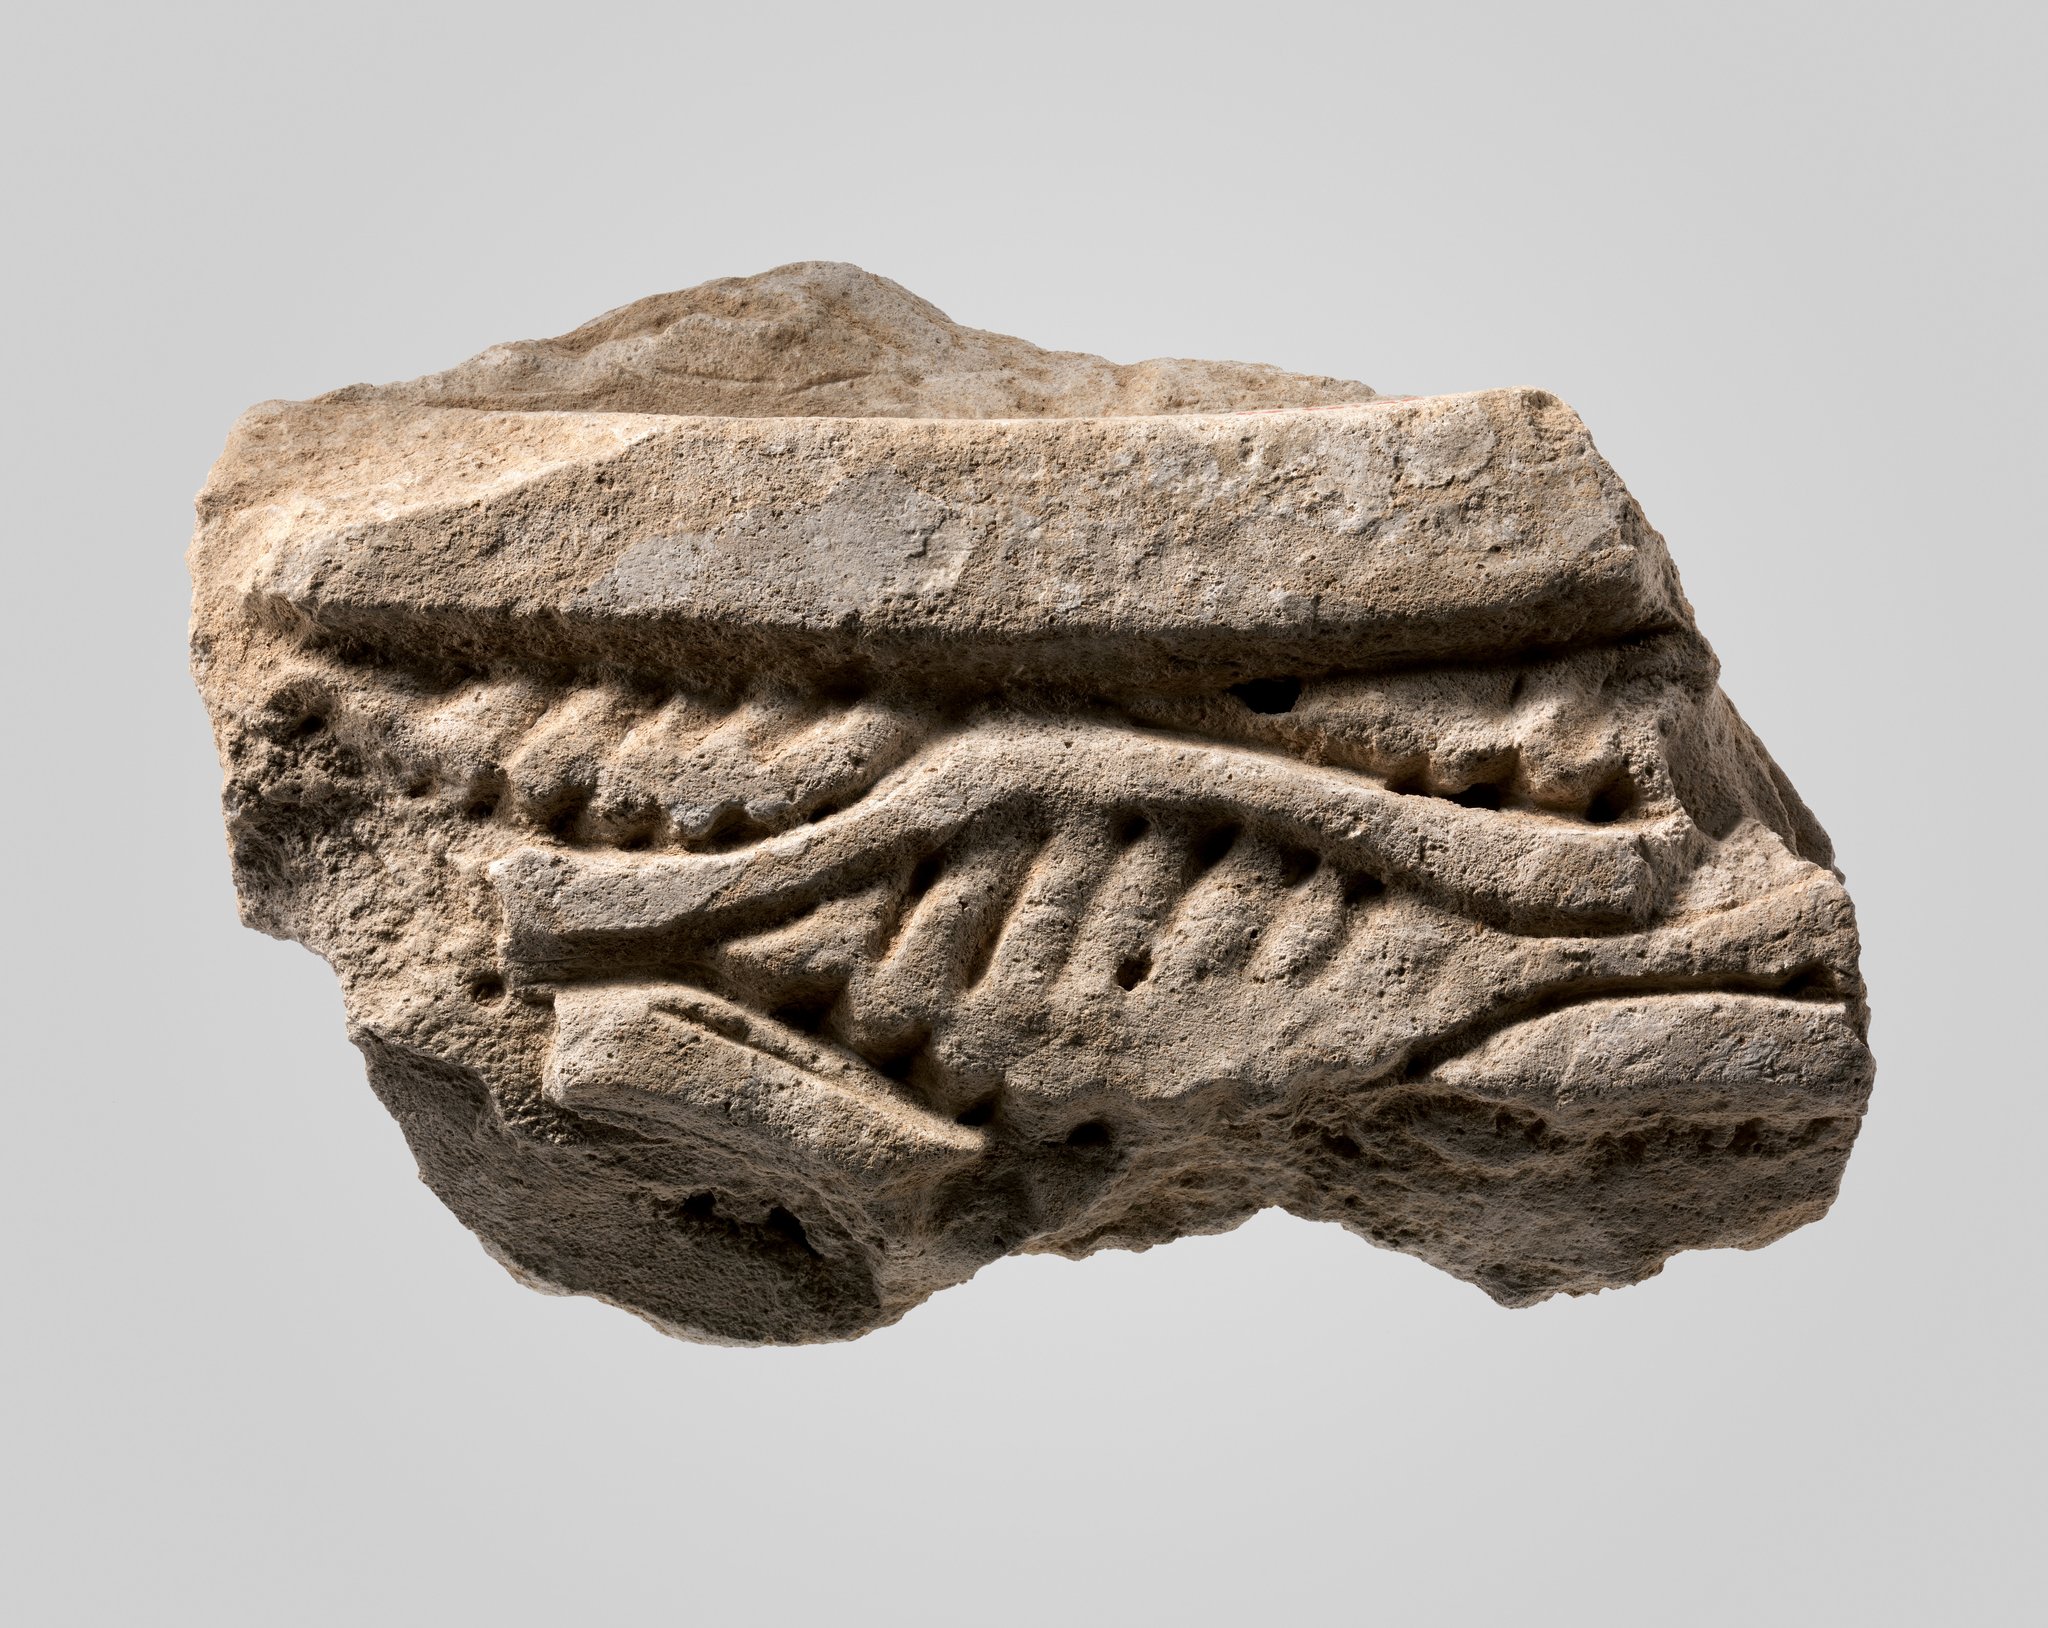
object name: relief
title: Relief fragment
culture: sasanian or islamic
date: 501-800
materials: plaster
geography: mesopotamia